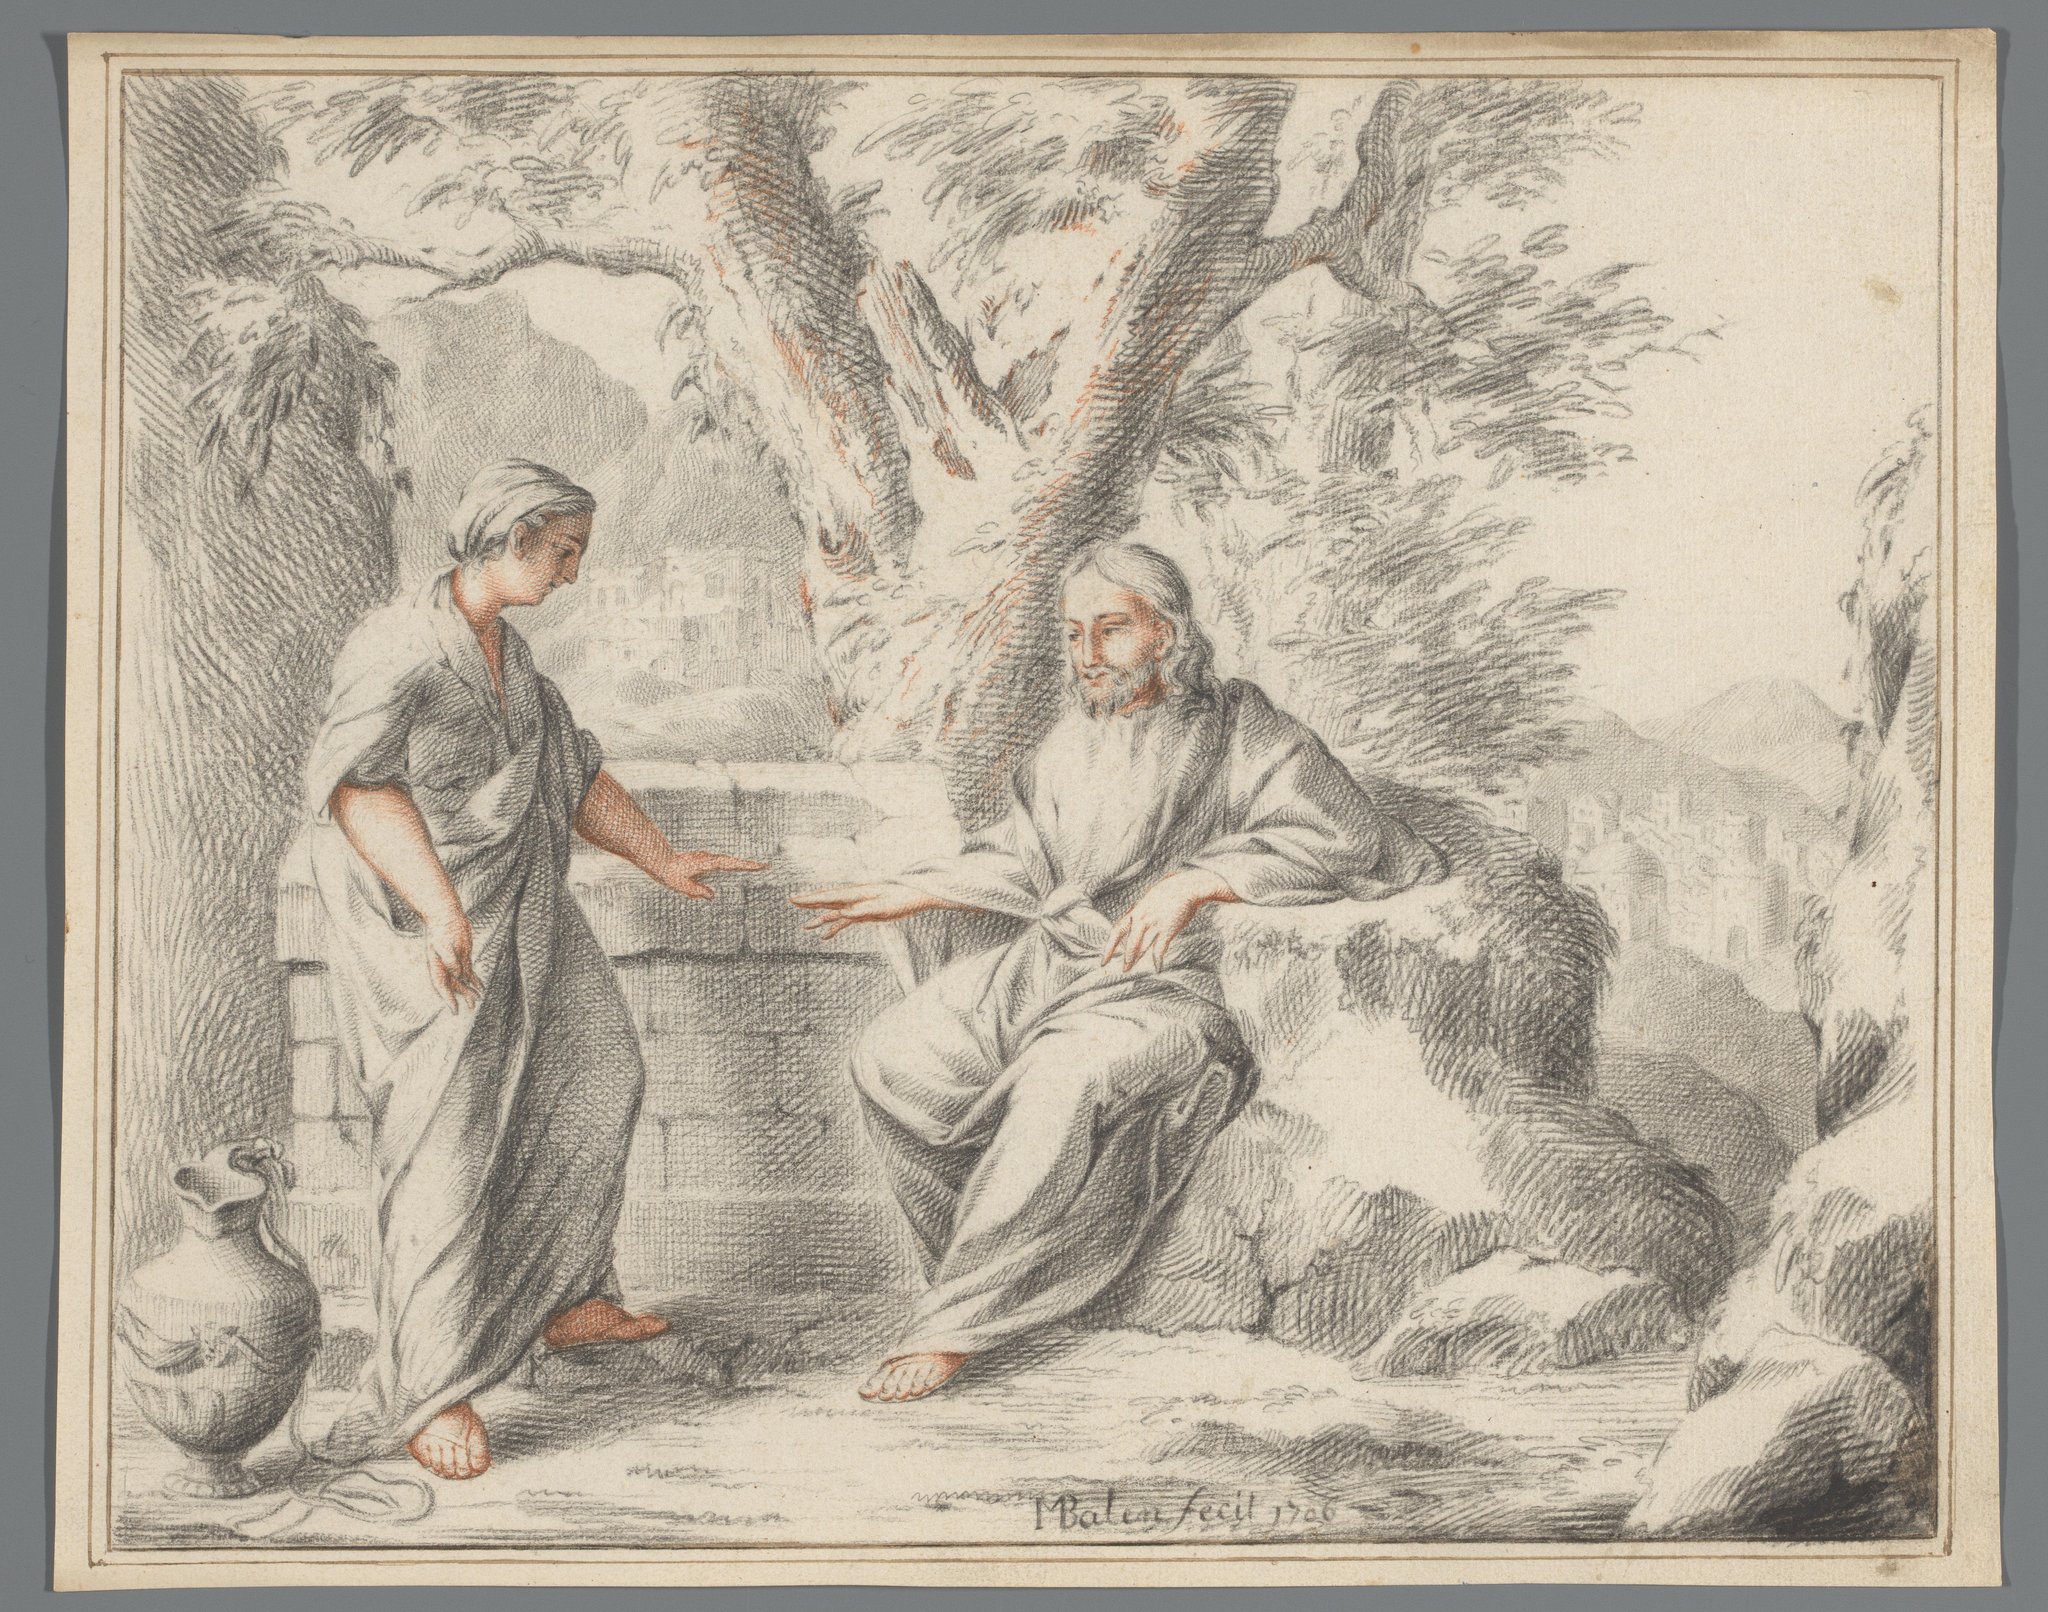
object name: drawing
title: Christus en de Samaritaanse vrouw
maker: matthijs balen (1684-1766)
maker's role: draughtsman, painter, print maker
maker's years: 1684-1766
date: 1706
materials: chalk, paper, pencil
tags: christ and the woman of samaria: sitting at jacob's well he asks her for a drink from her jug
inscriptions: date